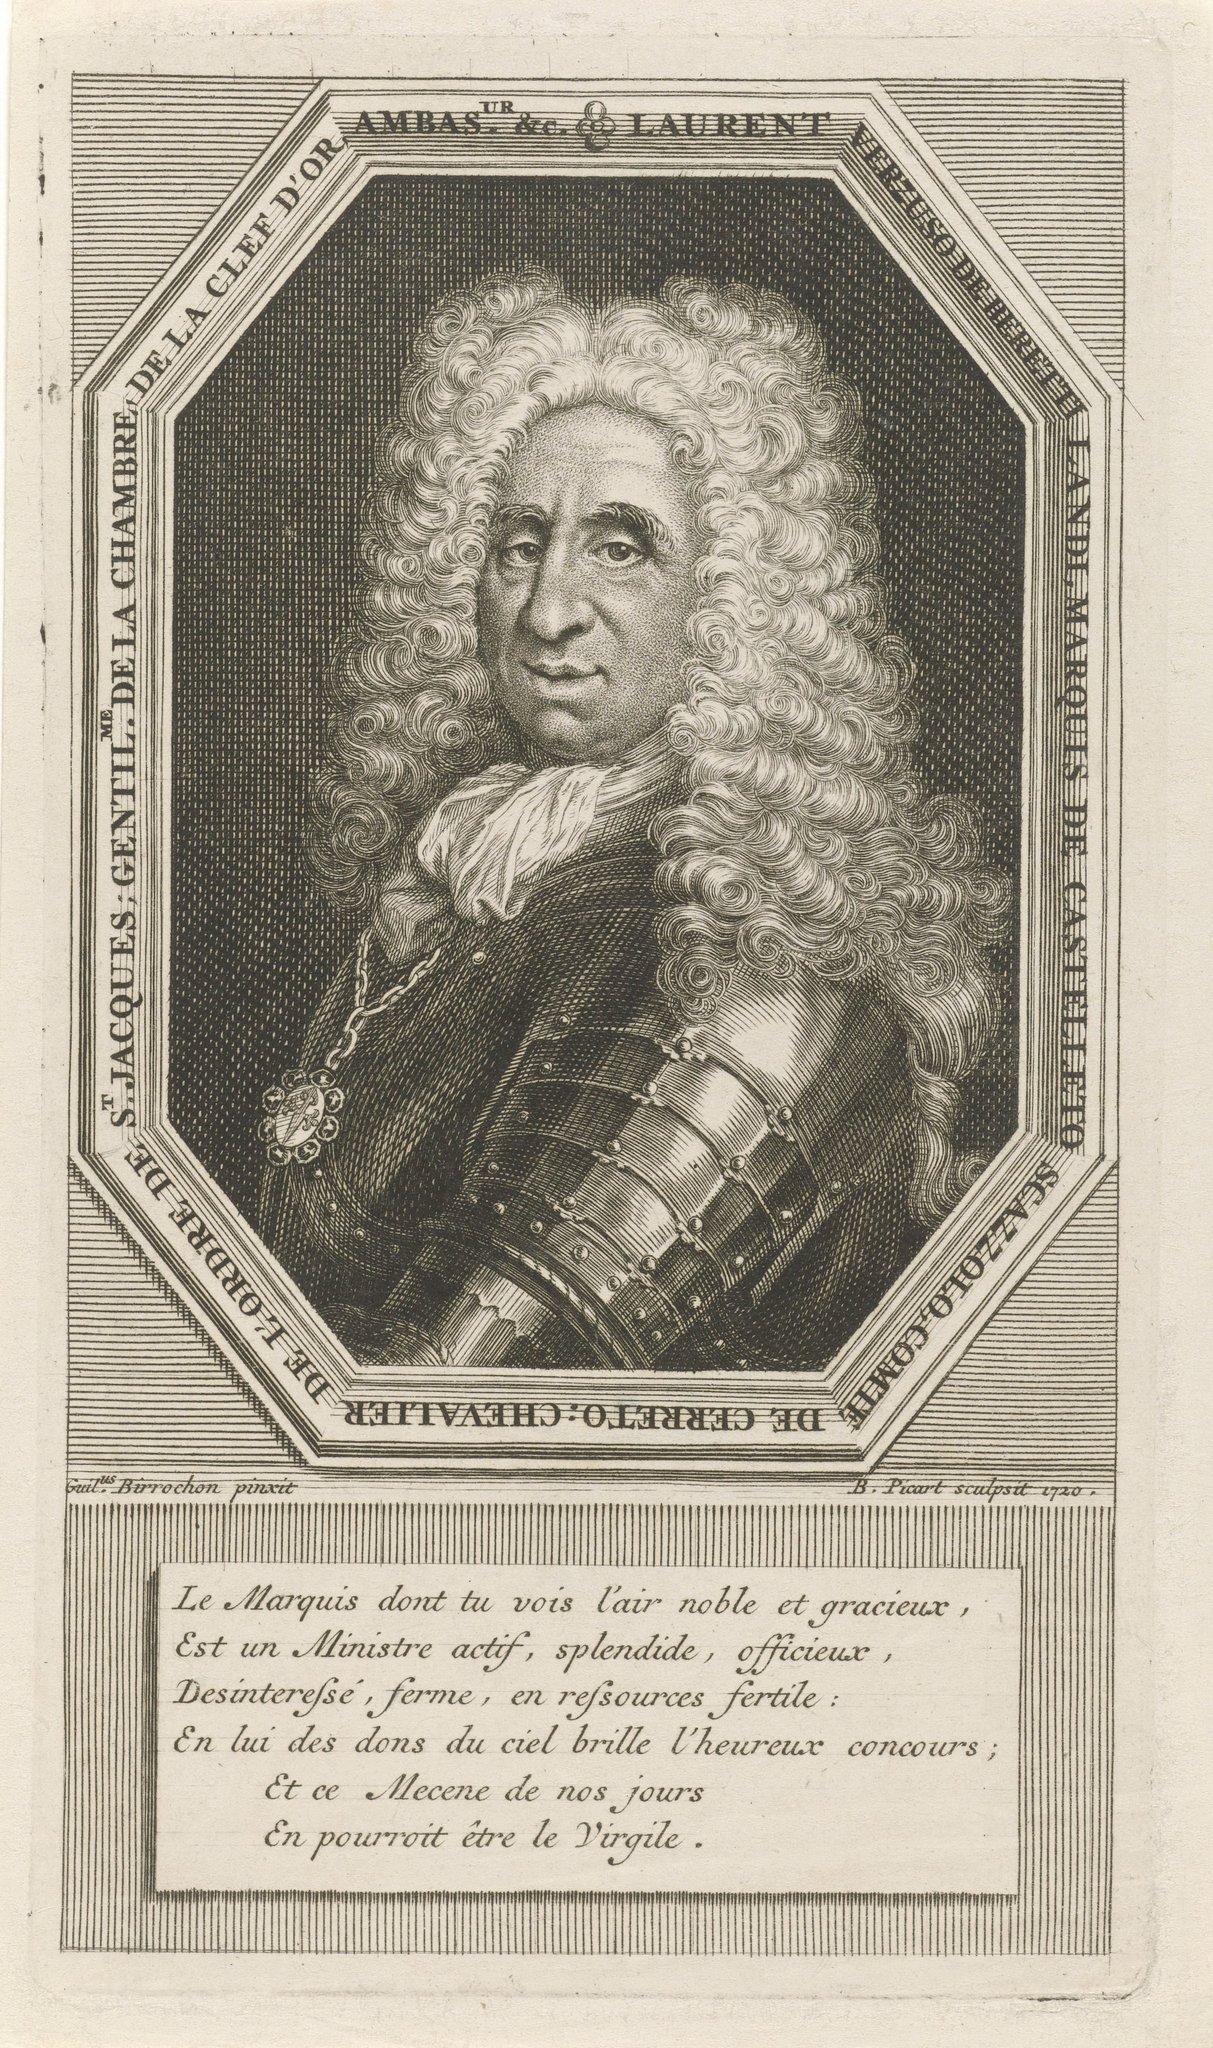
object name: print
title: Portret van Lorenzo di Vergiuso, markies van Beretti-Landi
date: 1720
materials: paper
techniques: engraving, etching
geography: amsterdam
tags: armour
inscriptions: collector's mark: Lugt 2228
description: Portret van Lorenzo di Vergiuso, markies van Beretti-Landi: Italiaans edelman in Spaanse dienst als ambassadeur in Den Haag. In het kader een zesregelig onderschrift in het Frans.